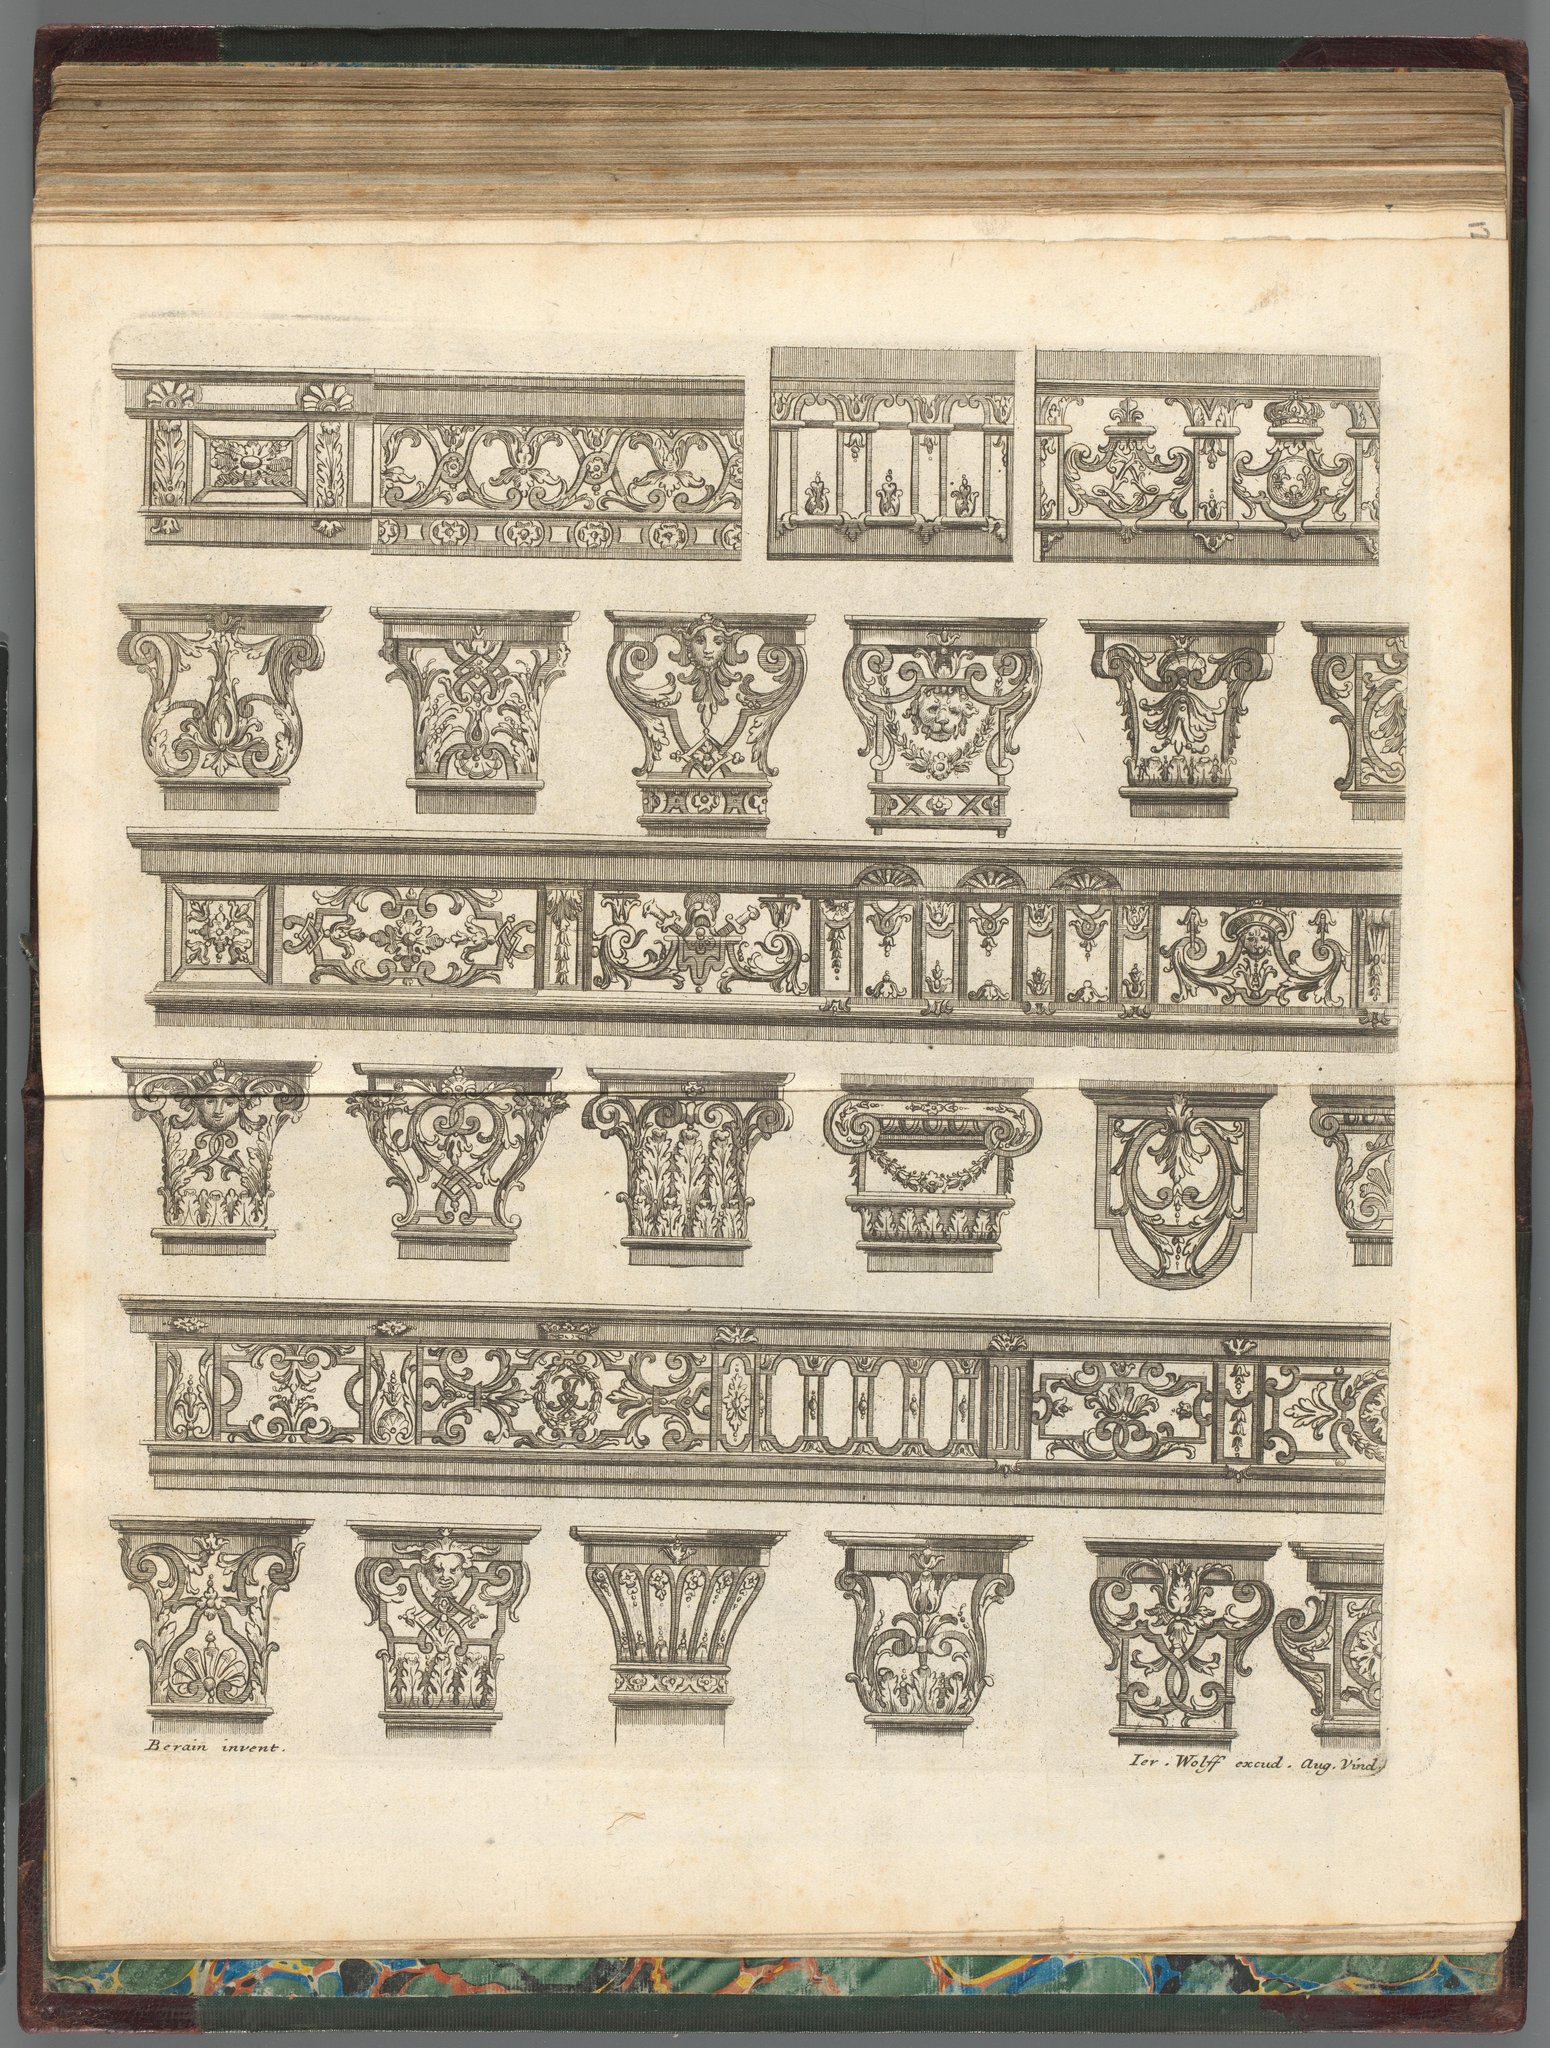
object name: album leaf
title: Ontwerpen voor hoofdgestellen en kapitelen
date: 1686-1724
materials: paper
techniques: etching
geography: augsburg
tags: ornaments ~ art, other architectural details (entablature), capital (~ column, pillar)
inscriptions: signature: ‘Ier. Wolff excud. Aug. Vind.’, signature: ‘Berain invent.’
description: Zes rijen met alternerend ontwerpen van hoofdgestellen en kapitelen. Vijfde prent uit een serie van vijf. Prent maakt deel uit van een album. Gespiegelde kopie naar Frans origineel.